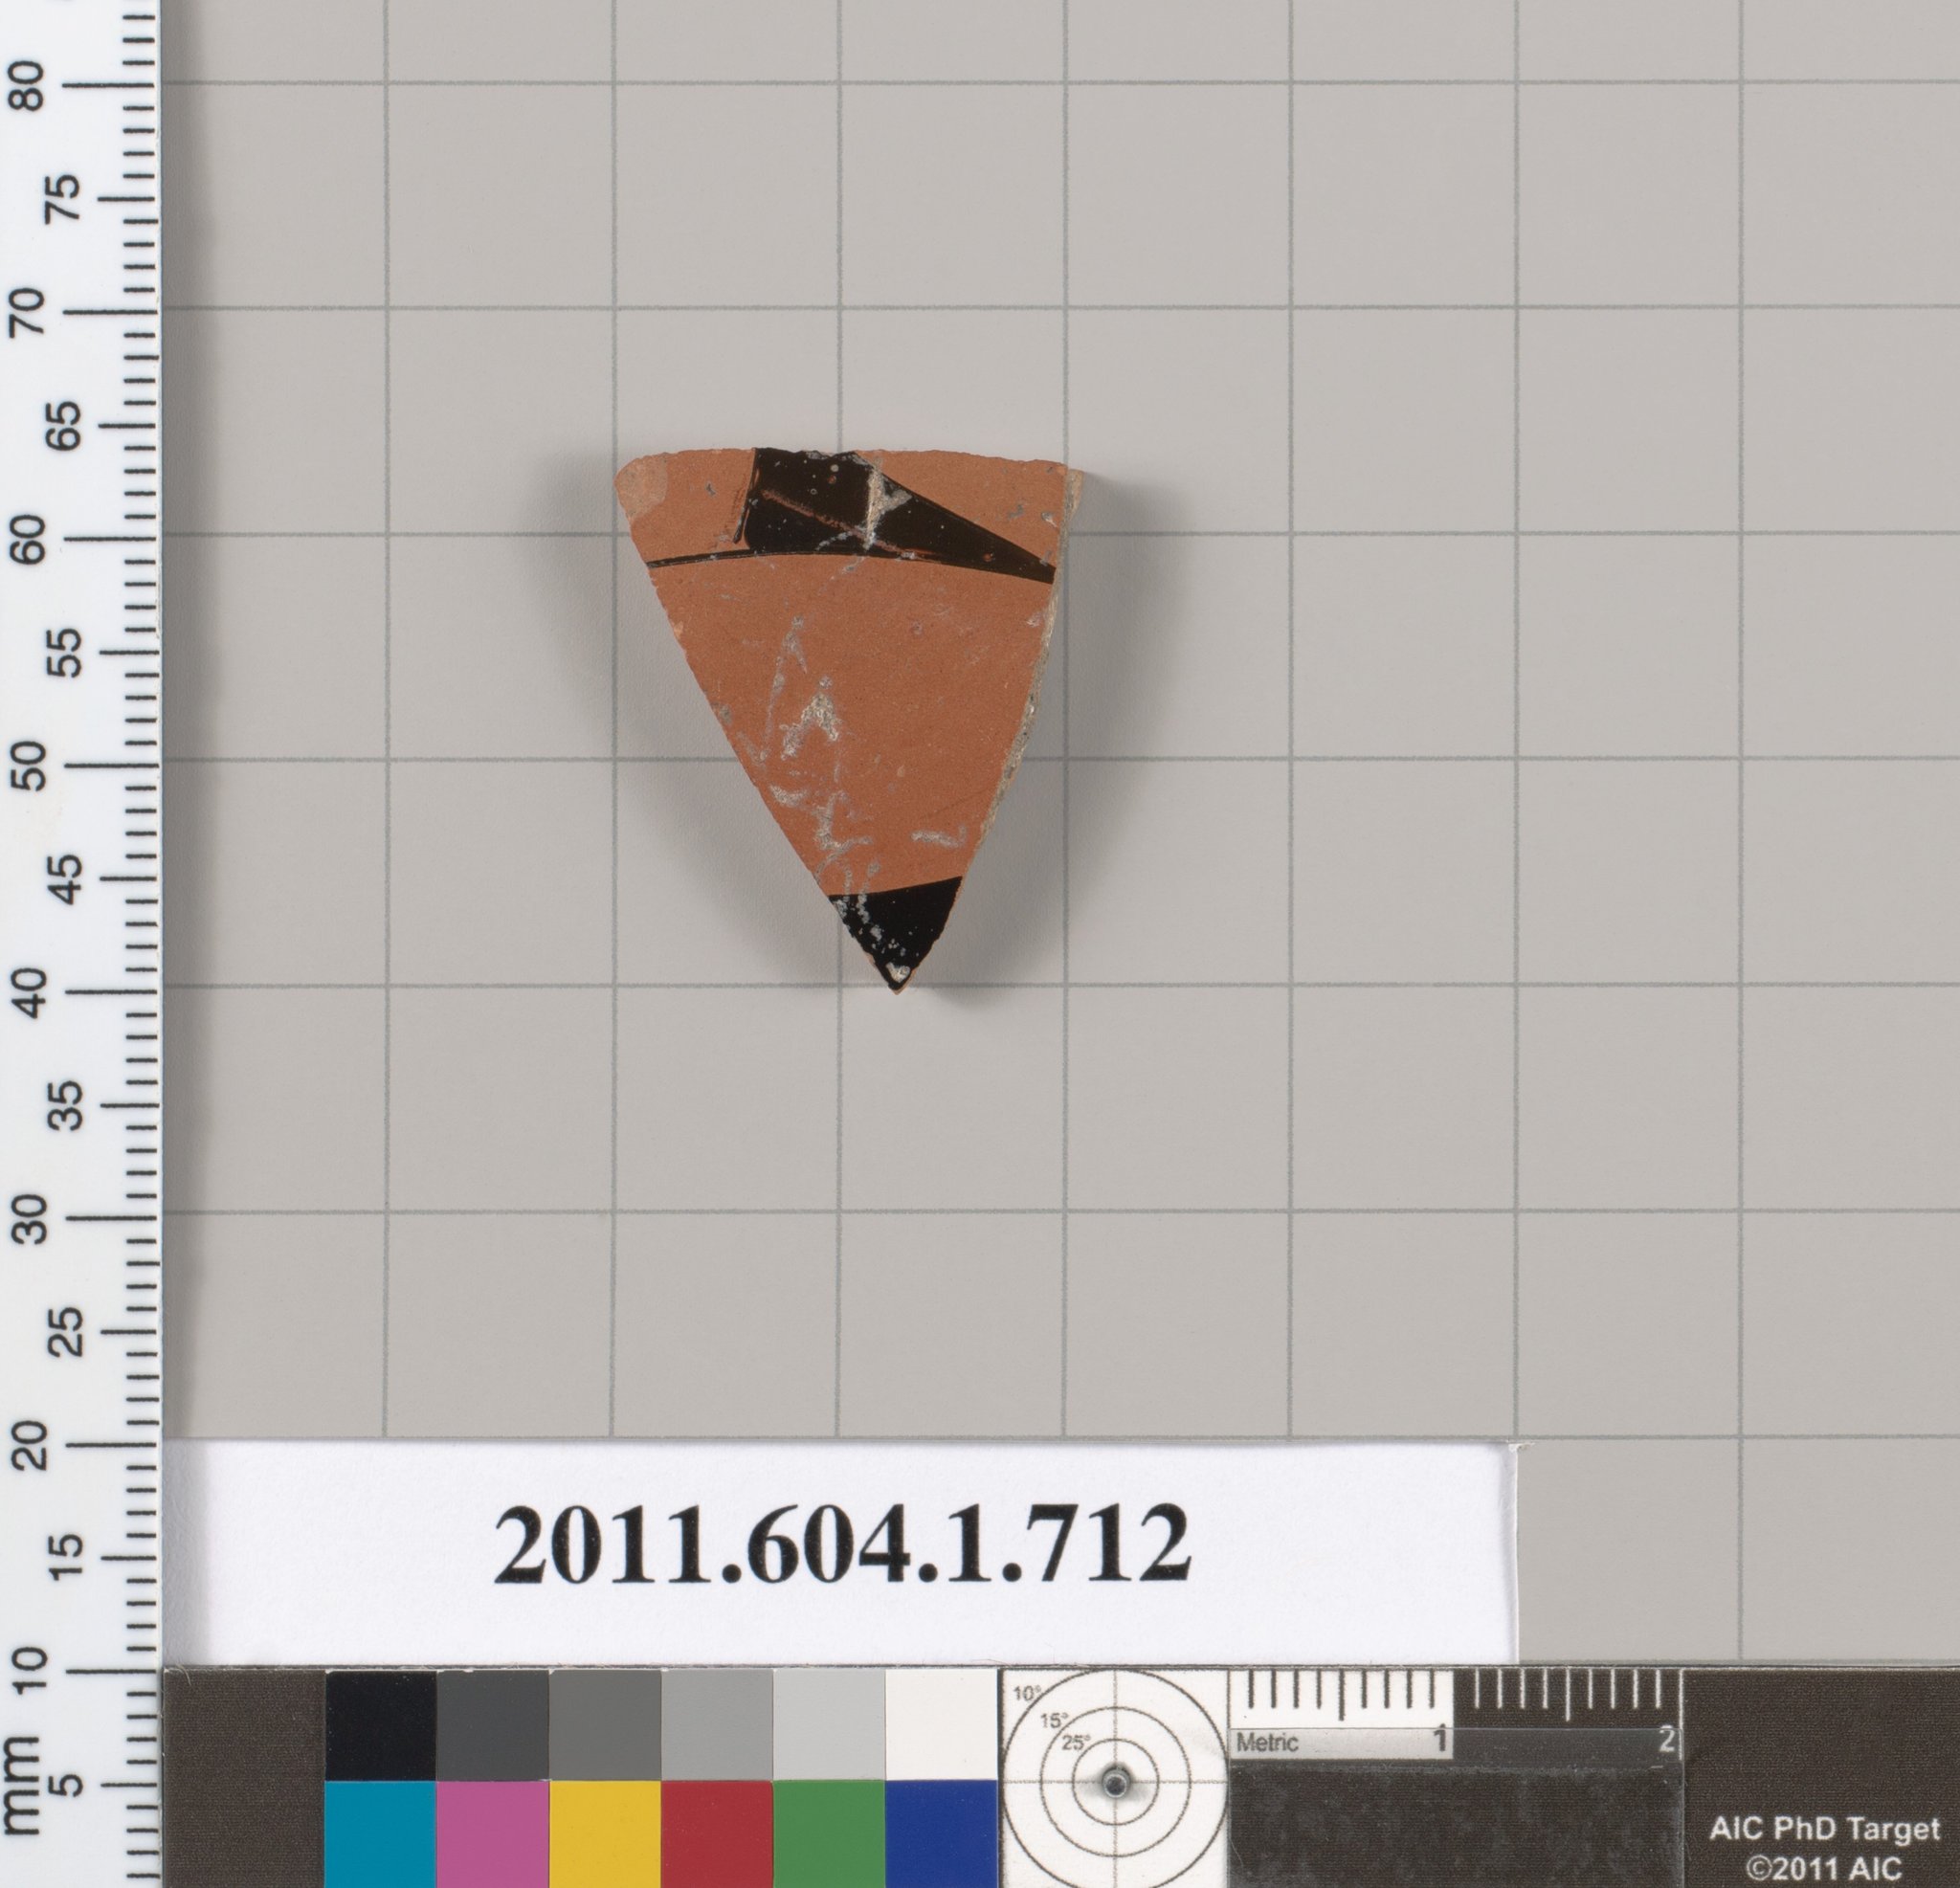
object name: kylix fragment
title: Terracotta fragment of a kylix (drinking cup)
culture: greek, attic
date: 475-451 BCE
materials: terracotta